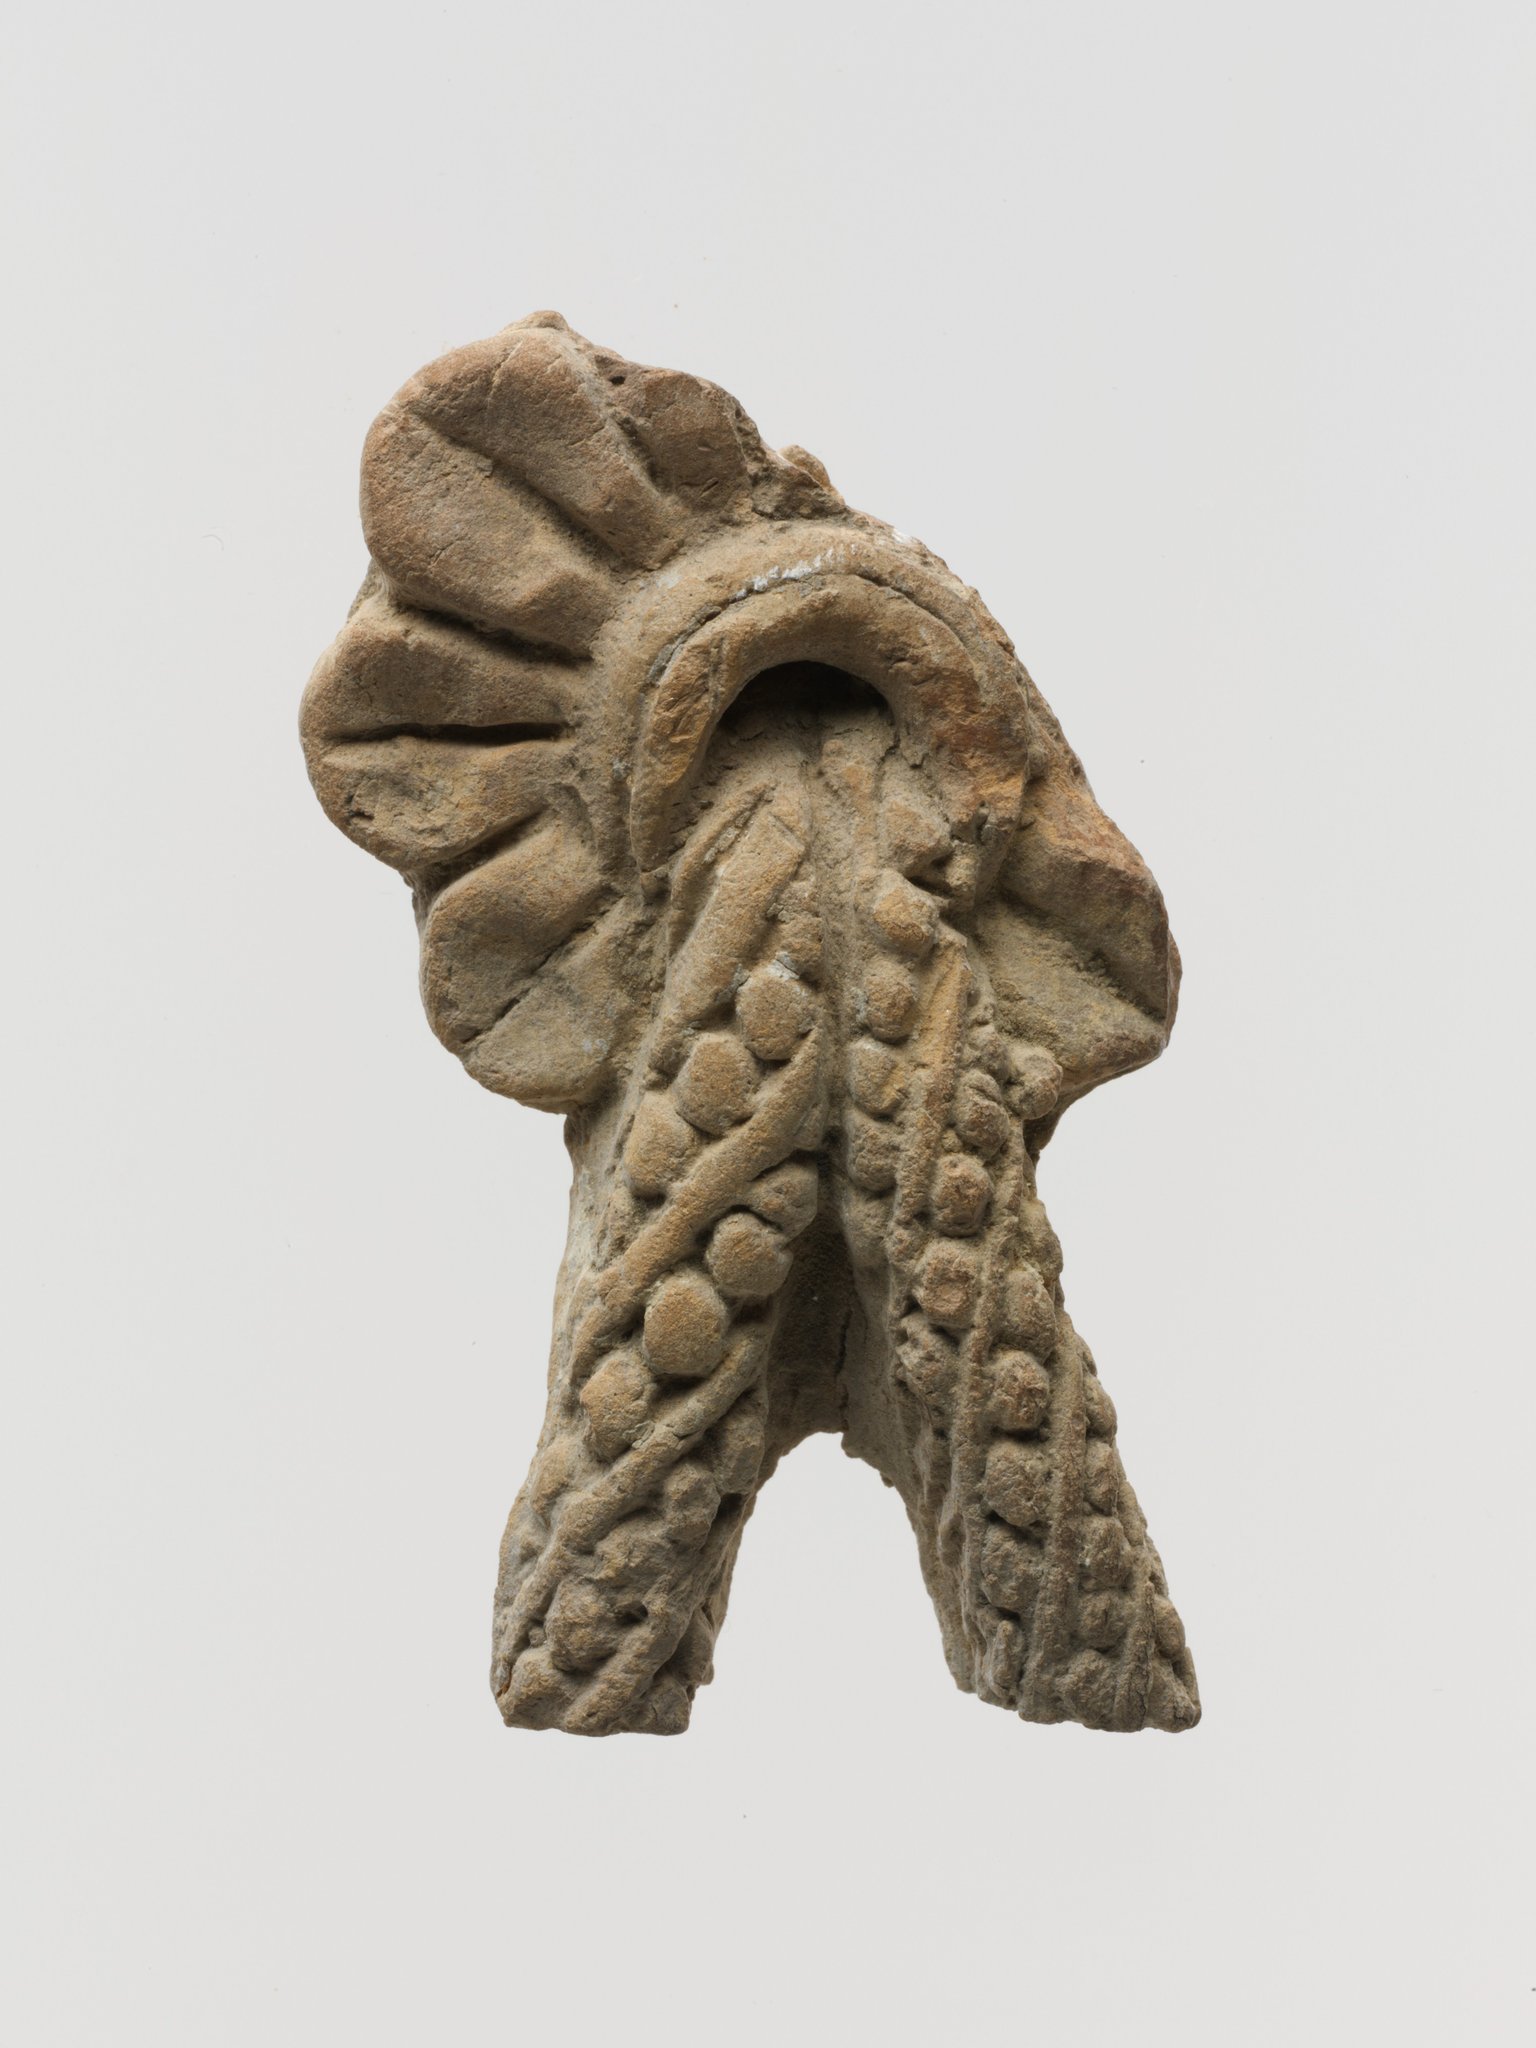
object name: molded fragment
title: Molded Appliqué Ornament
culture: west chinese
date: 101-500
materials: earthenware